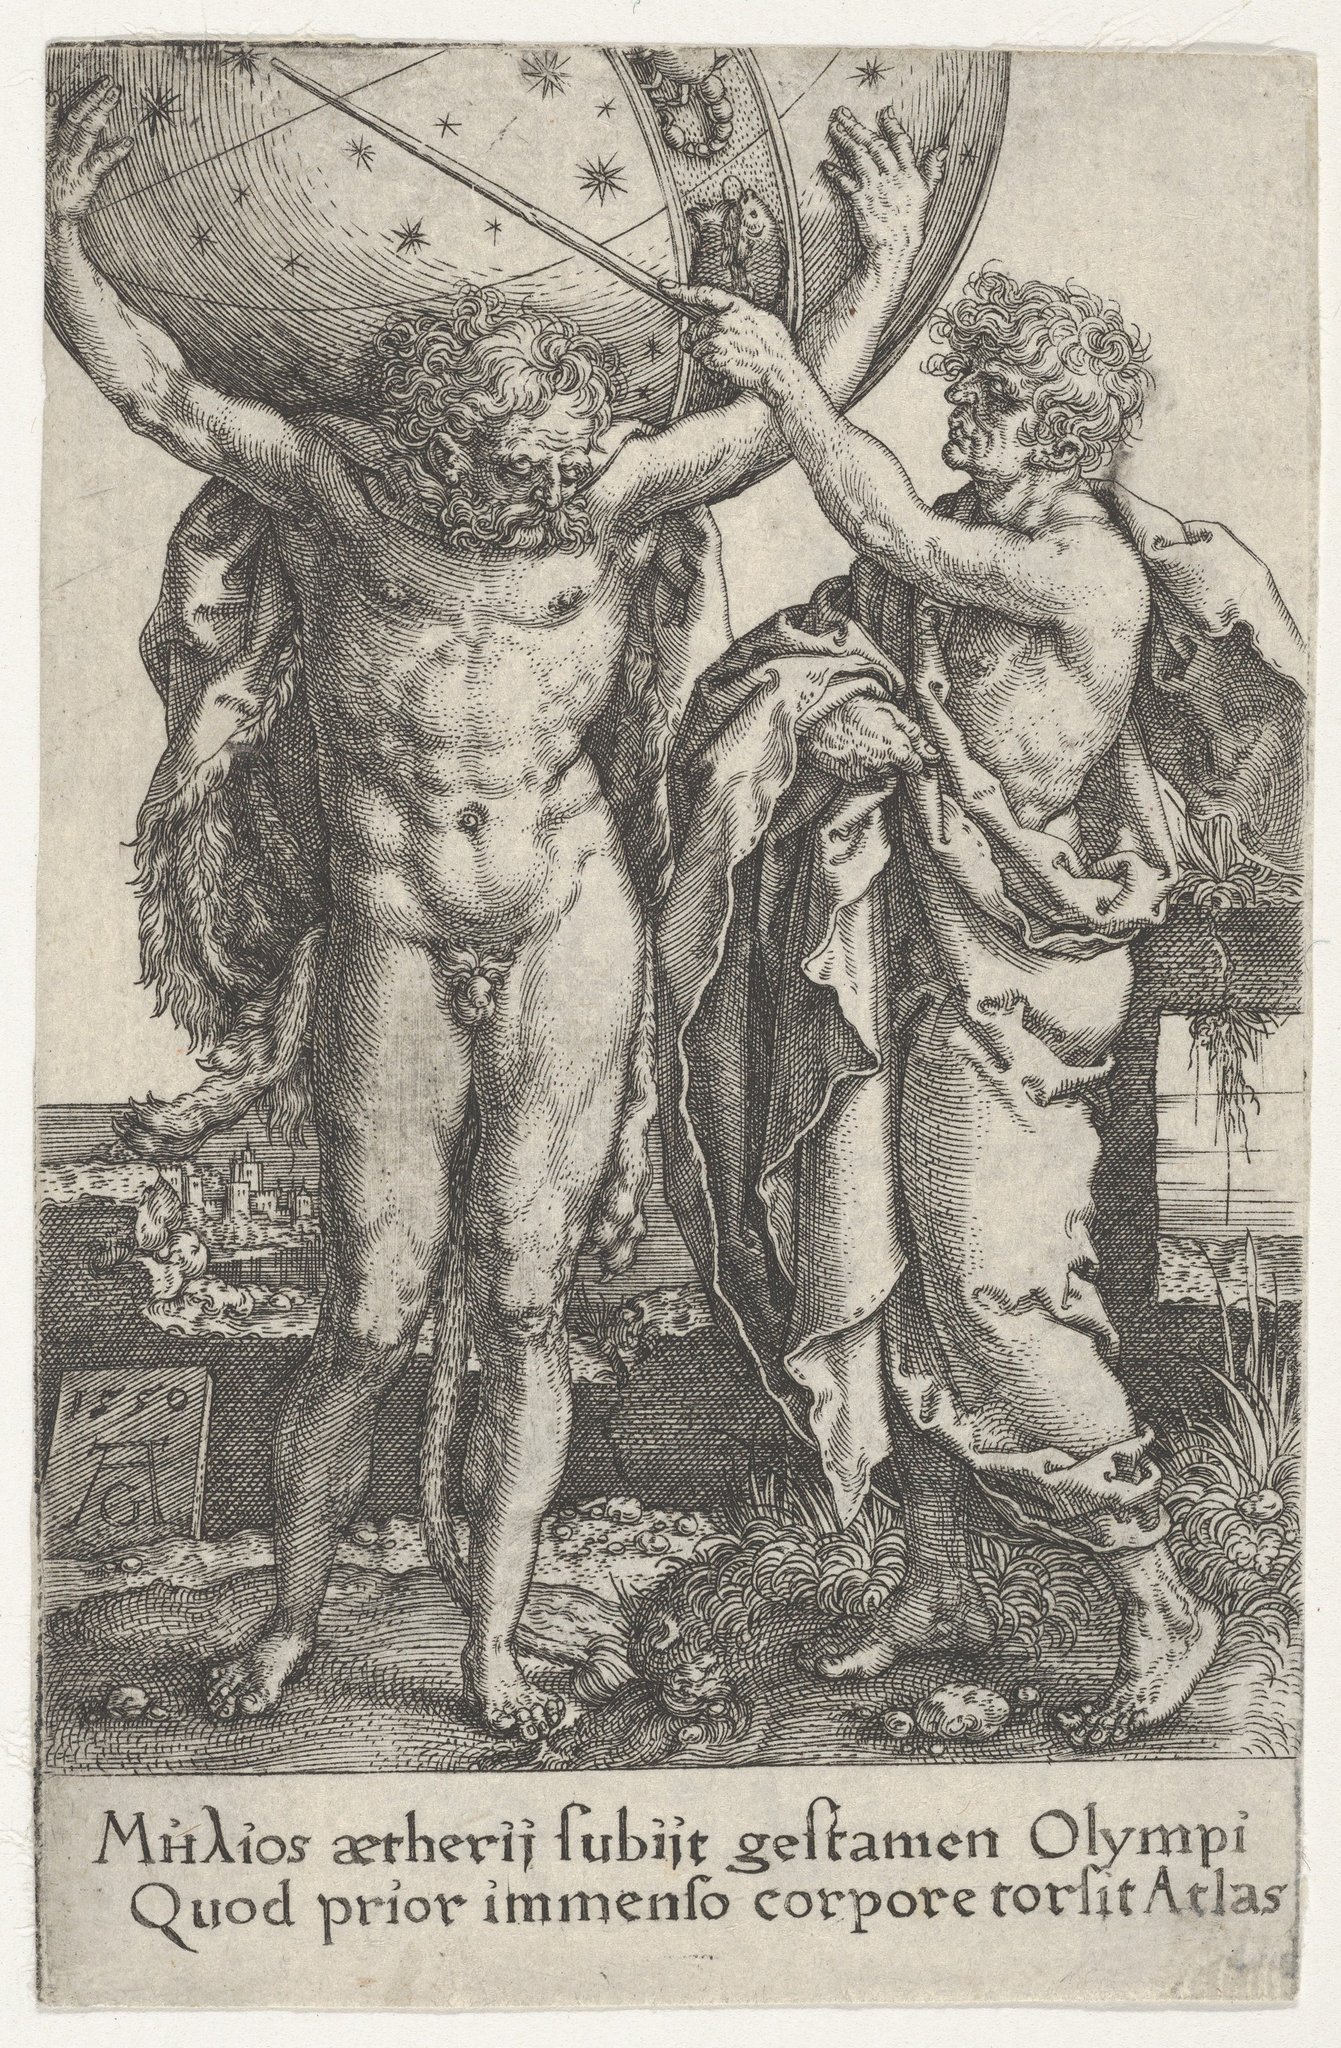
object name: print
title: Hercules and Atlas, from "The Labors of Hercules"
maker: heinrich aldegrever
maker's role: artist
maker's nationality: german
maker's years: 1502-1561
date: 1550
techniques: engraving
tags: male nudes,hercules,globes